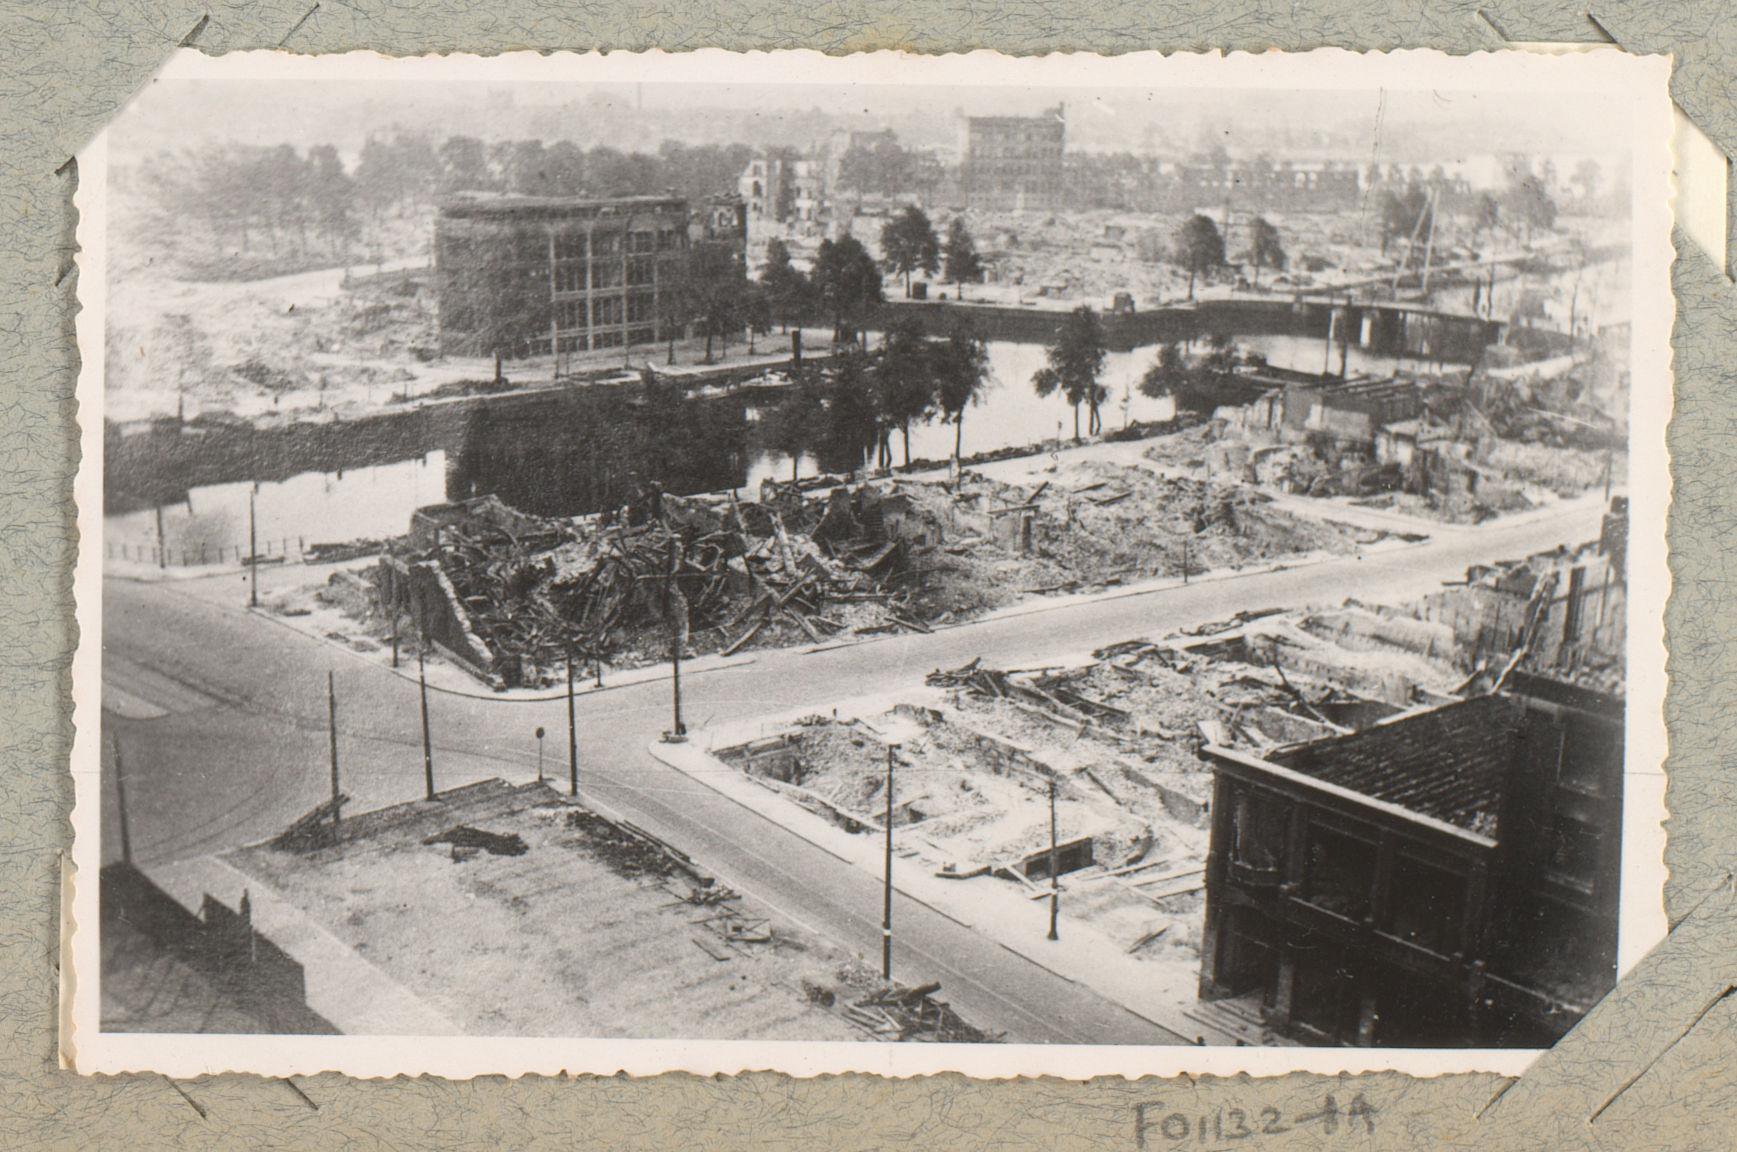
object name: photograph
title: Ruïnes bij de Leuvehaven te Rotterdam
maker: j. nolte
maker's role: fotograaf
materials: photographic support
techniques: gelatin silver print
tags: devastated, ruined place or city (~ warfare), rotterdam, rotterdam blitz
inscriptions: annotation: ‘Internationale Crediet en Handelsvereeniging 18/ Leuvehaven’